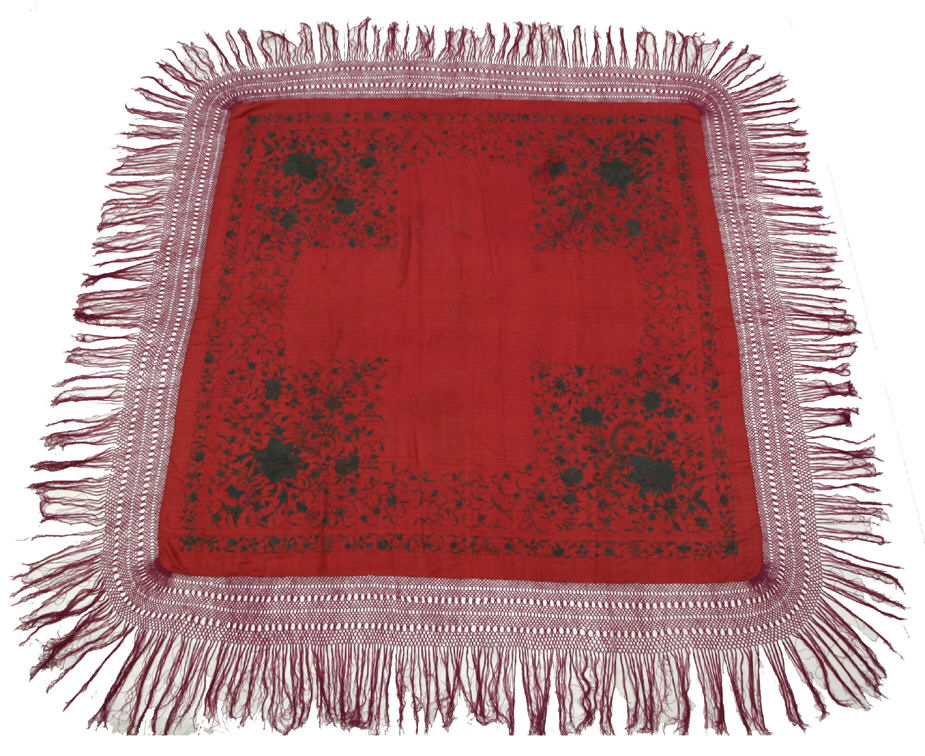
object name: shawl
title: Square Shawl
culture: chinese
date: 1901-1933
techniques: embroidery